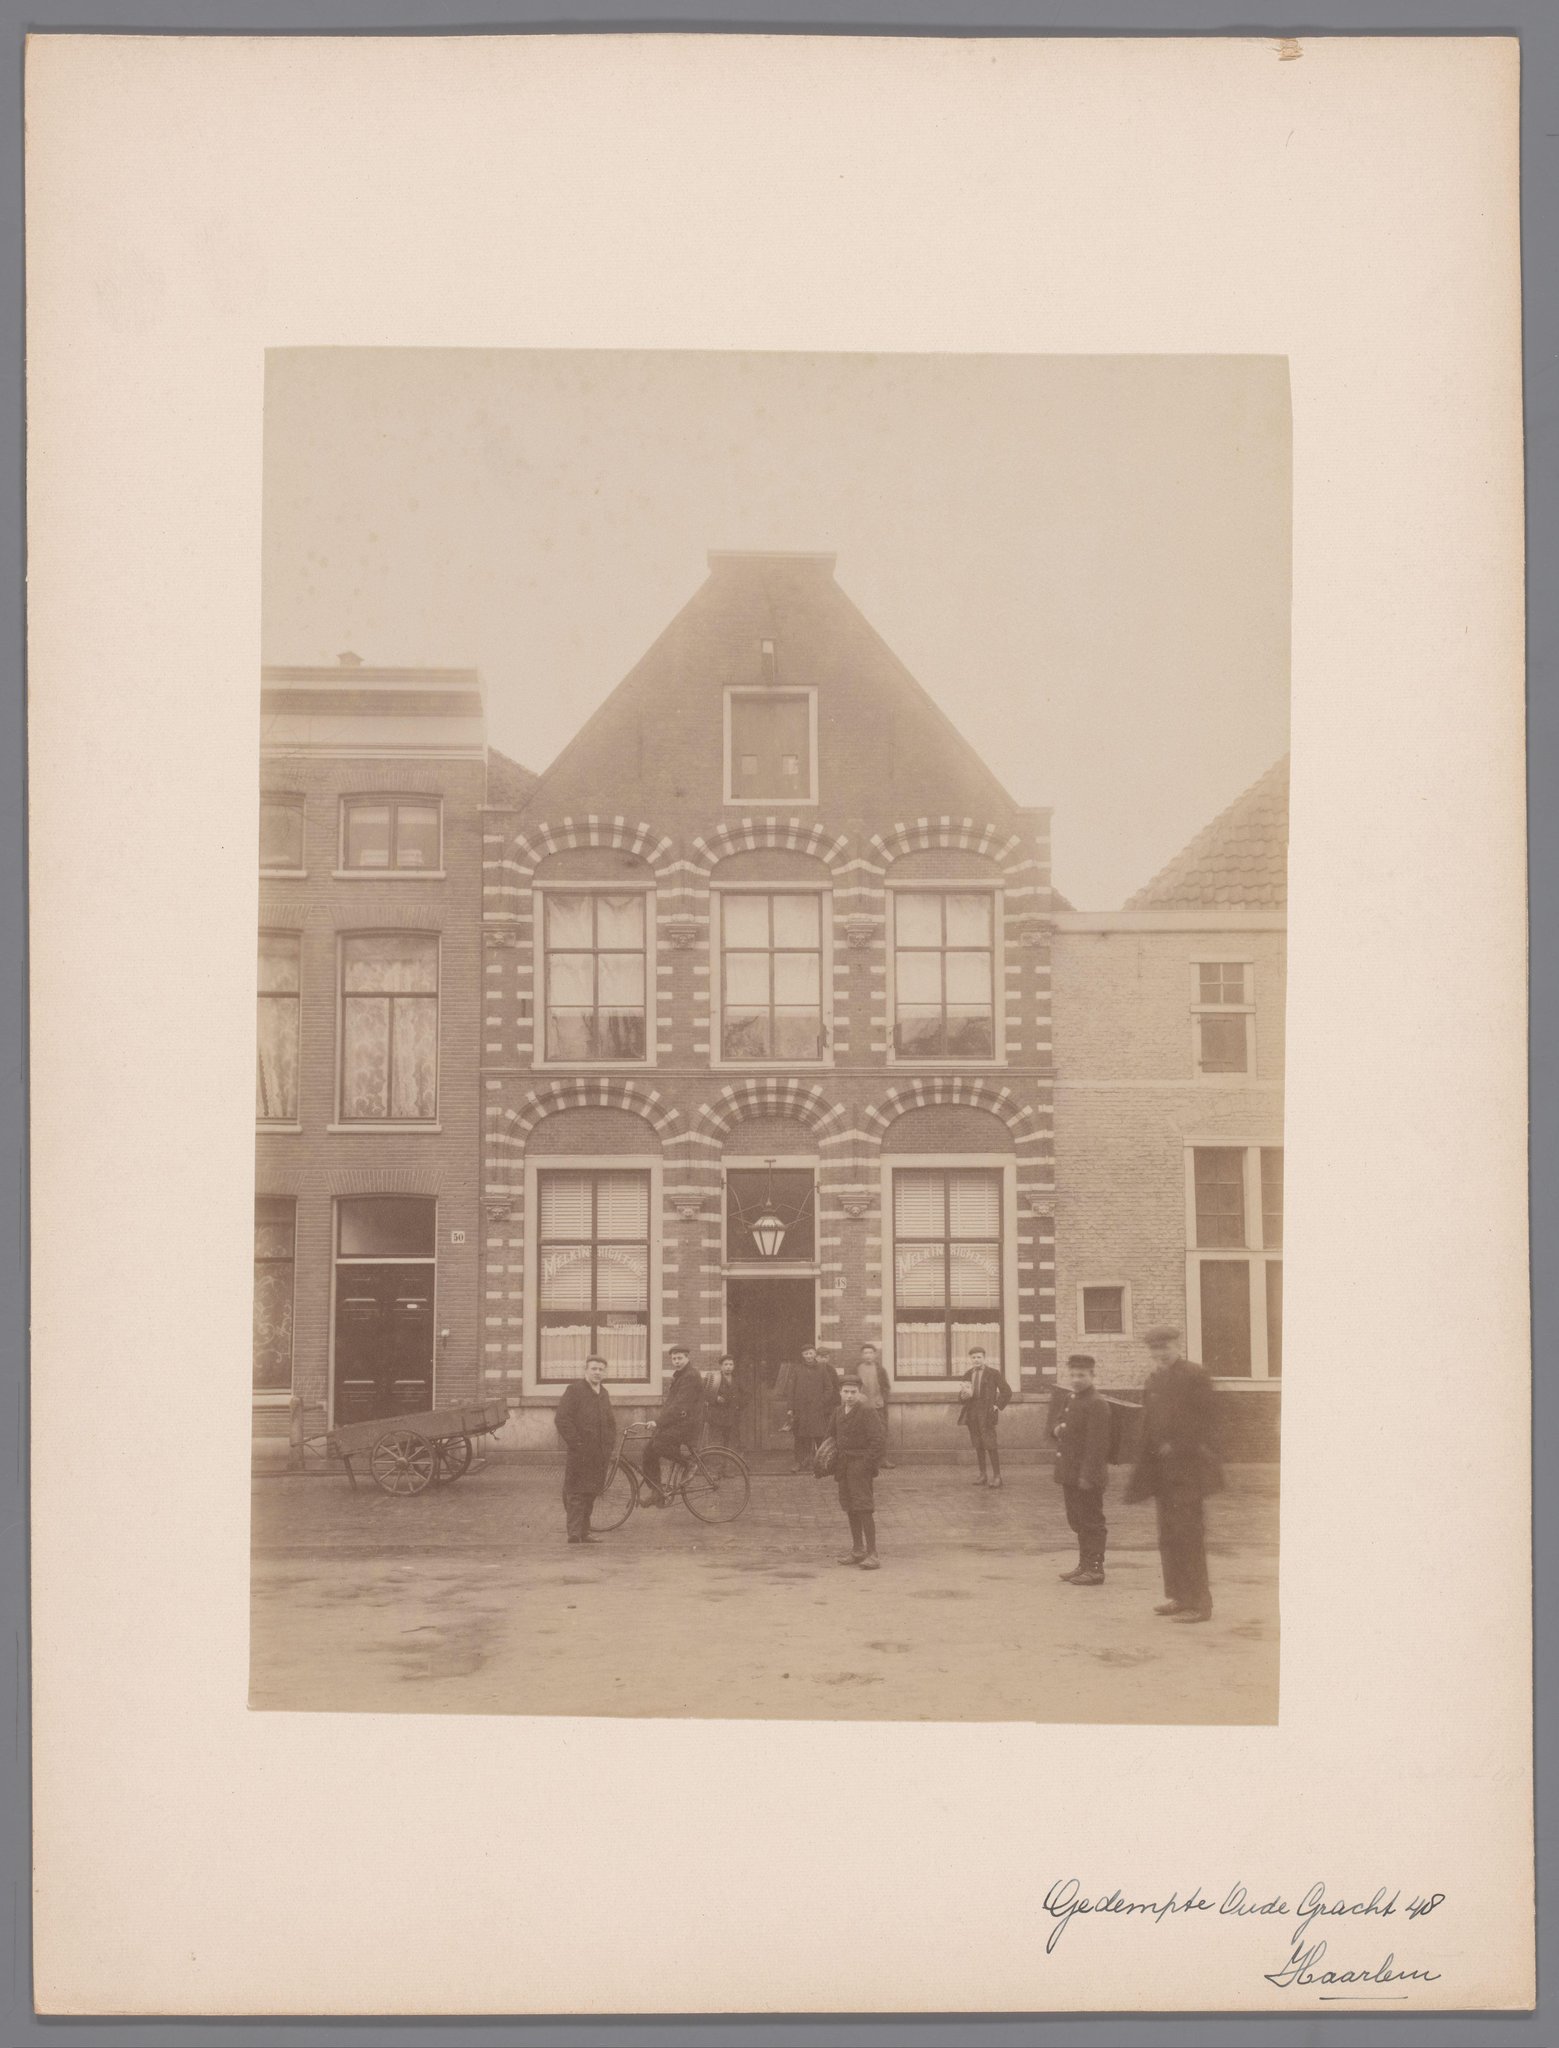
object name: photograph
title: Pand op de Gedempte Oude Gracht 48 te Haarlem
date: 1880-1900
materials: cardboard, photographic support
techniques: albumen print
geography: gedempte oude gracht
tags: shop, store, façade (of house or building)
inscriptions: annotation: ‘Haarlem (woonhuis gedempte oude gracht 48 - (N.H.)’, annotation: ‘Gedempte Oude Gracht 48/ Haarlem’